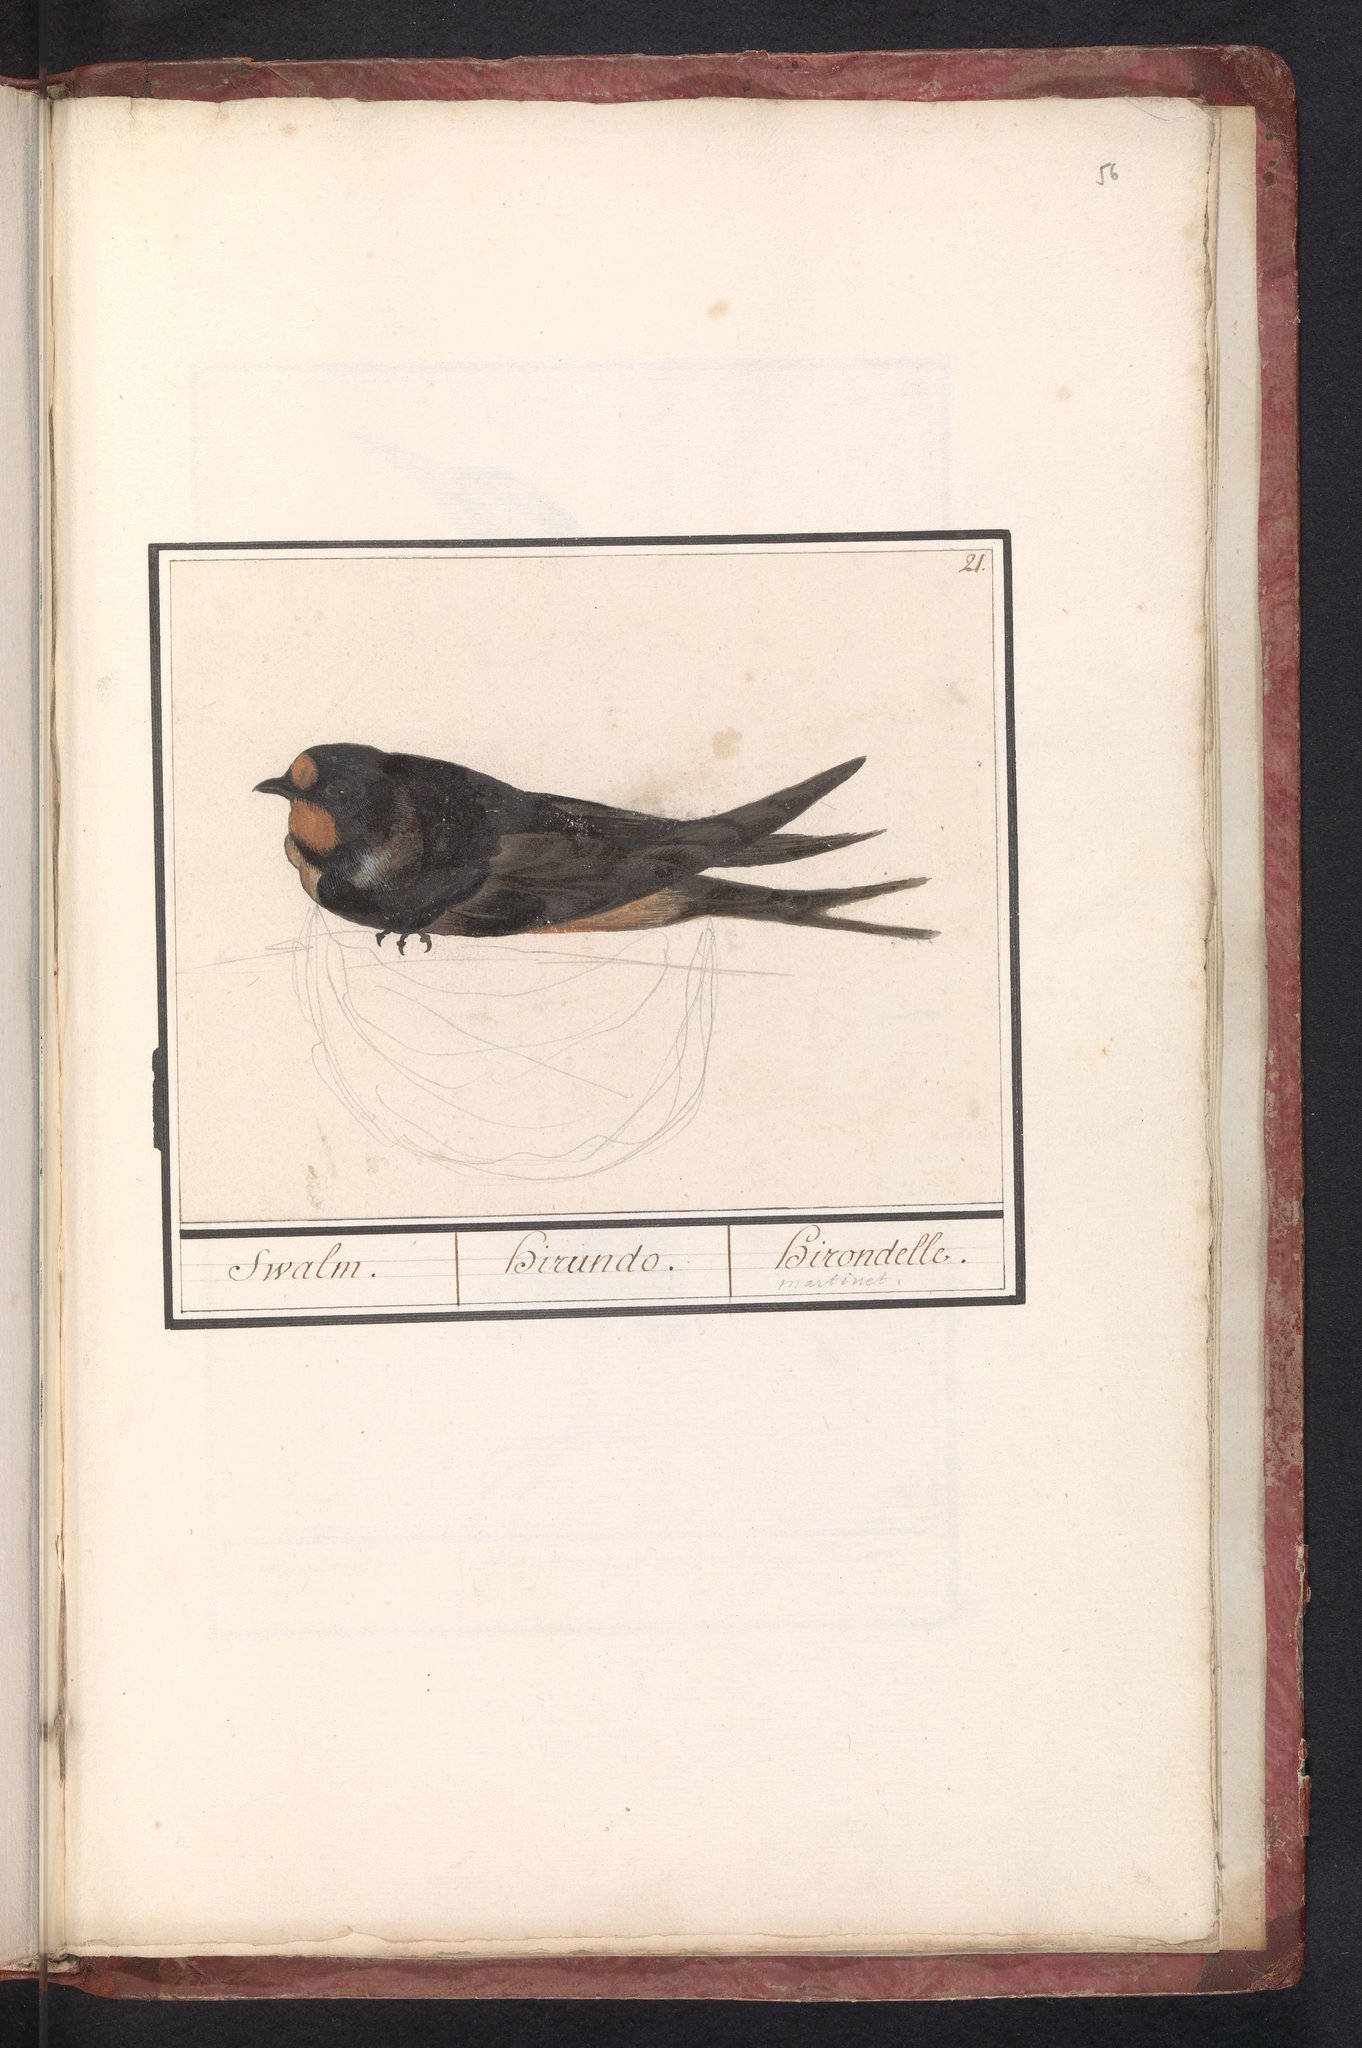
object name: drawing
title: Barn Swallow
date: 1596-1610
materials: paint, paper, pencil, watercolor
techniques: brush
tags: song-birds: barn swallow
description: Boerenzwaluw. Genummerd rechtsboven: 21. Onderdeel van het tweede album met tekeningen van vogels. Vierde van twaalf albums met tekeningen van dieren, vogels en planten bekend rond 1600, gemaakt in opdracht van keizer Rudolf II. Met toelichting in Nederlands, Latijn en Frans.